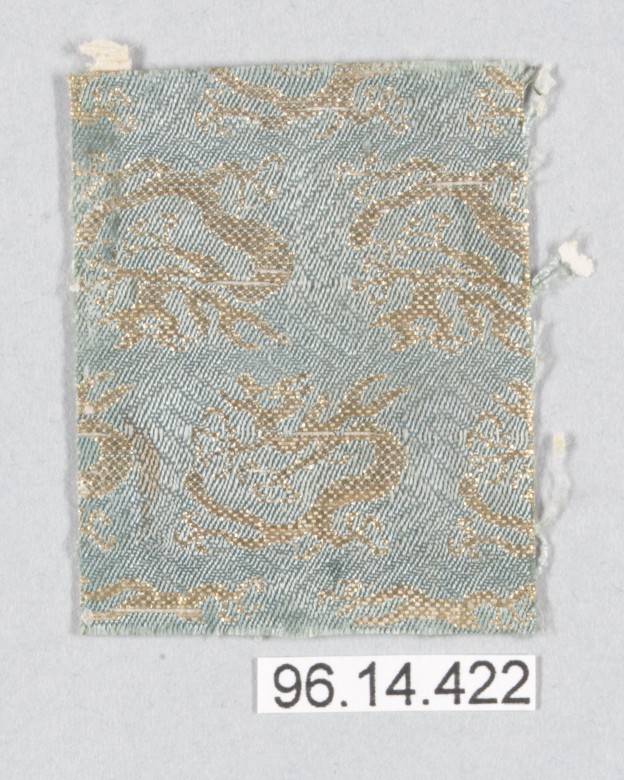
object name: piece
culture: japanese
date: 1701-1900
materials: silk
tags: dragons